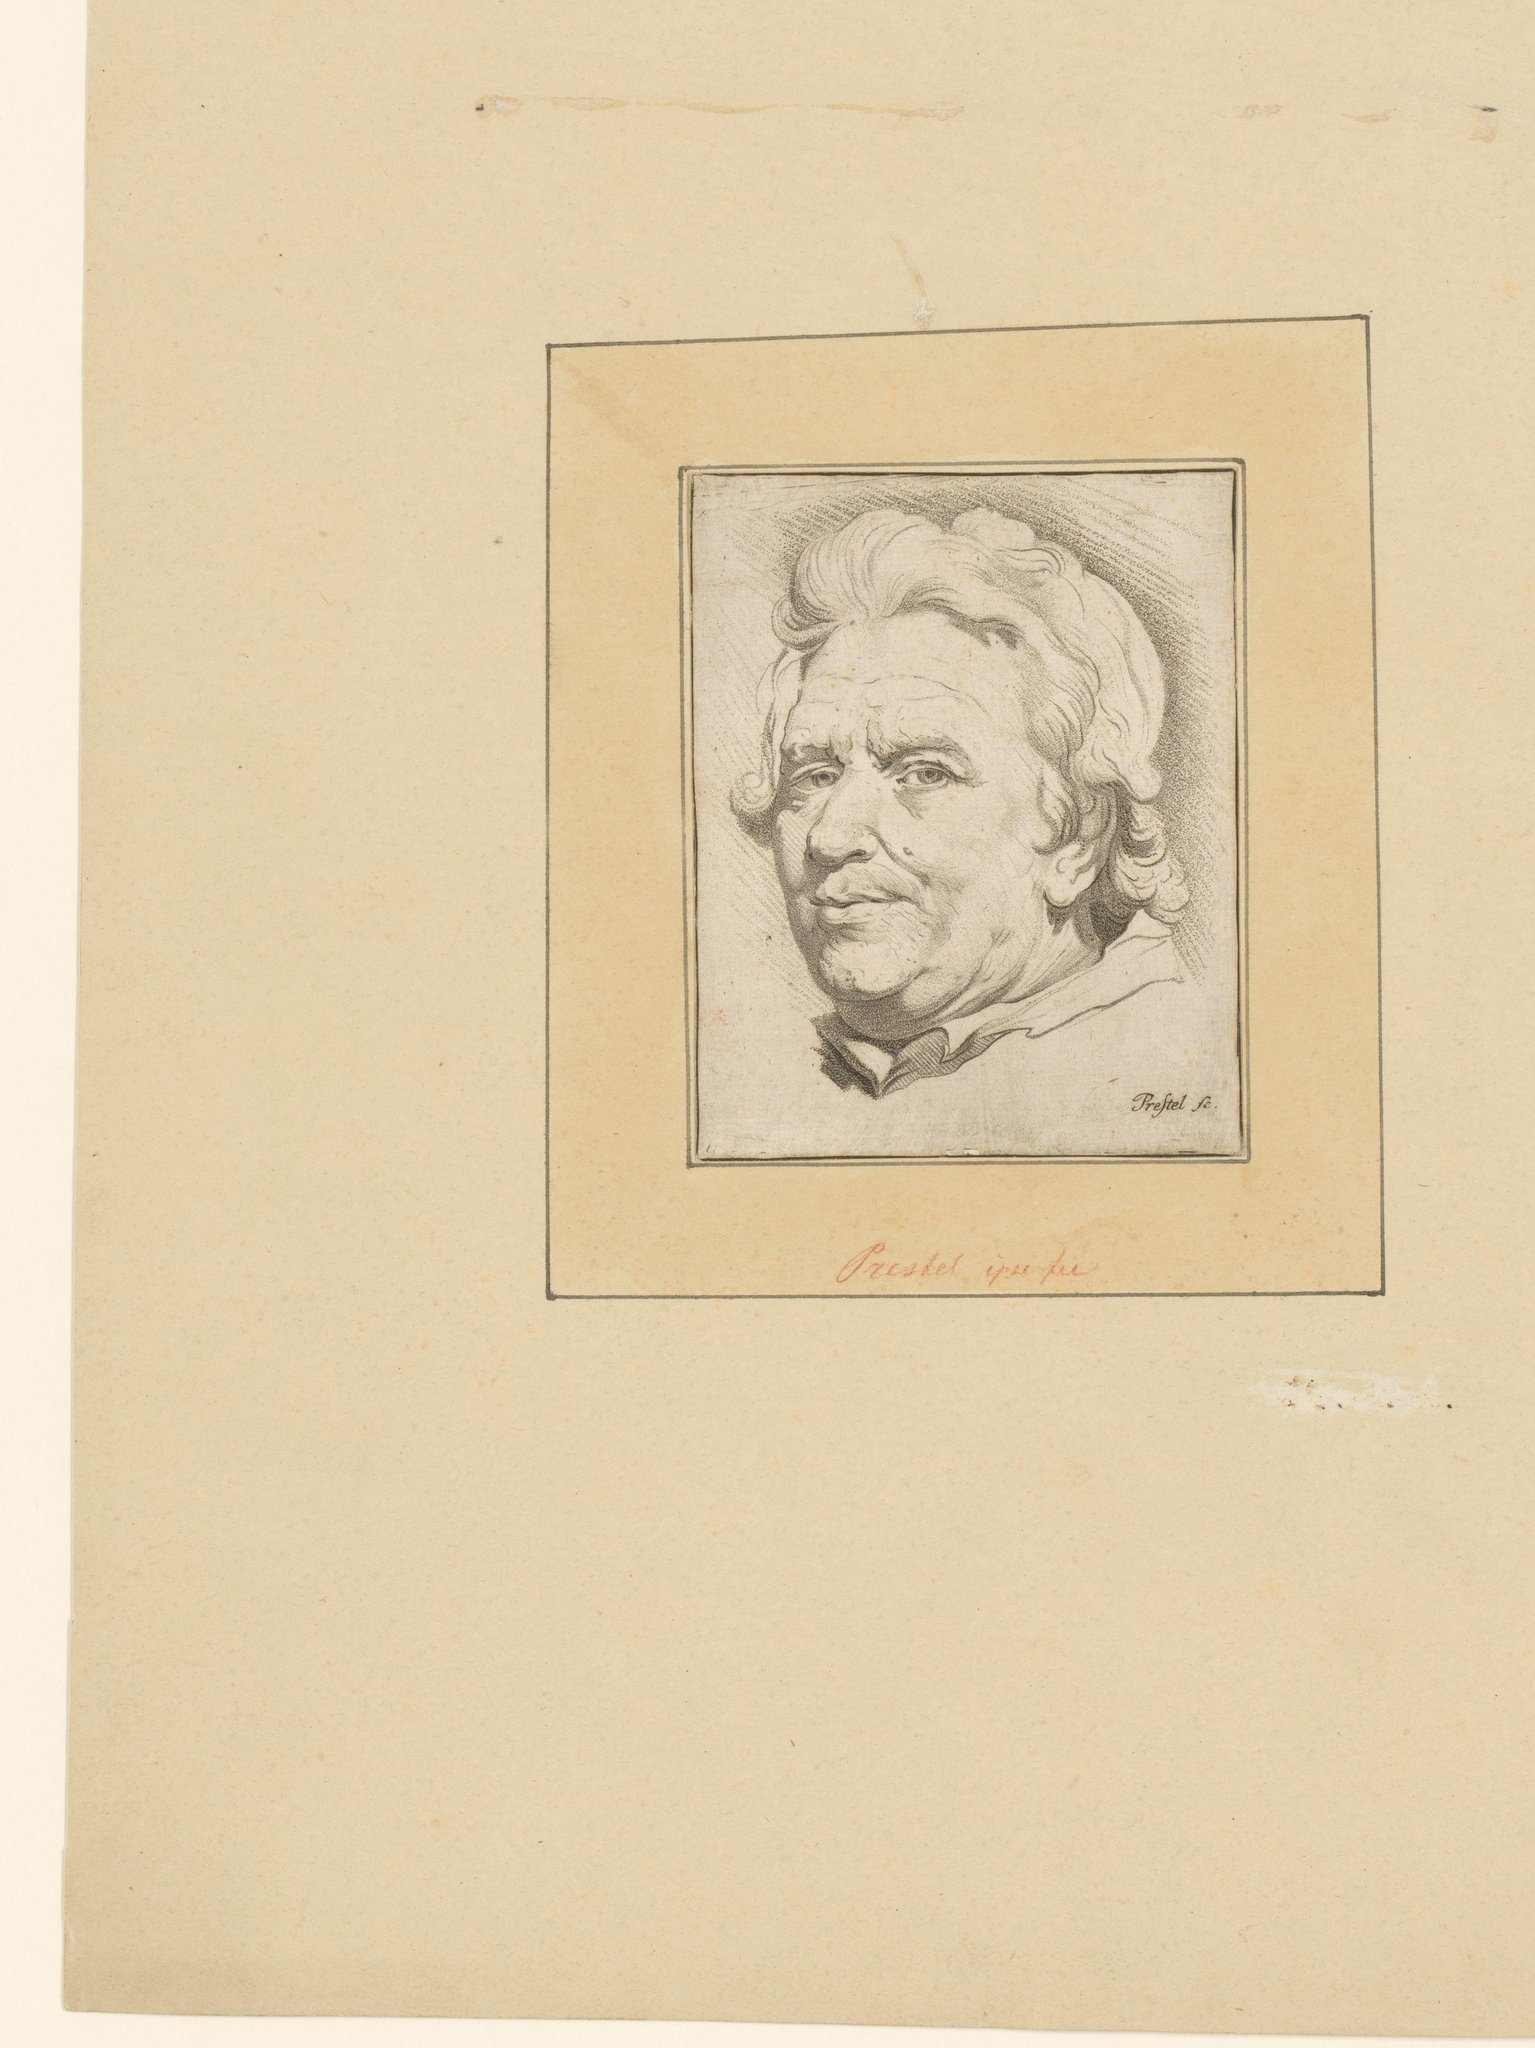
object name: print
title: Portret van een onbekende man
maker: johann gottlieb prestel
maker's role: draughtsman, painter, print maker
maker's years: 1739-1808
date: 1783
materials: paper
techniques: printmaking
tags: historical persons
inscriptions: collector's mark: Lugt 2228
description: Nummer 2 uit het prentenalbum 'Dessins des meilleurs Peintres d'Italie, d'Allemagne, et des Pays-Bas, Tirés de divers célebres Cabinets. Gravés d'apres les Originaux de même grandeur par Jean Théophile Prestel'. Neurenberg: J.G. Prestel, 1783.